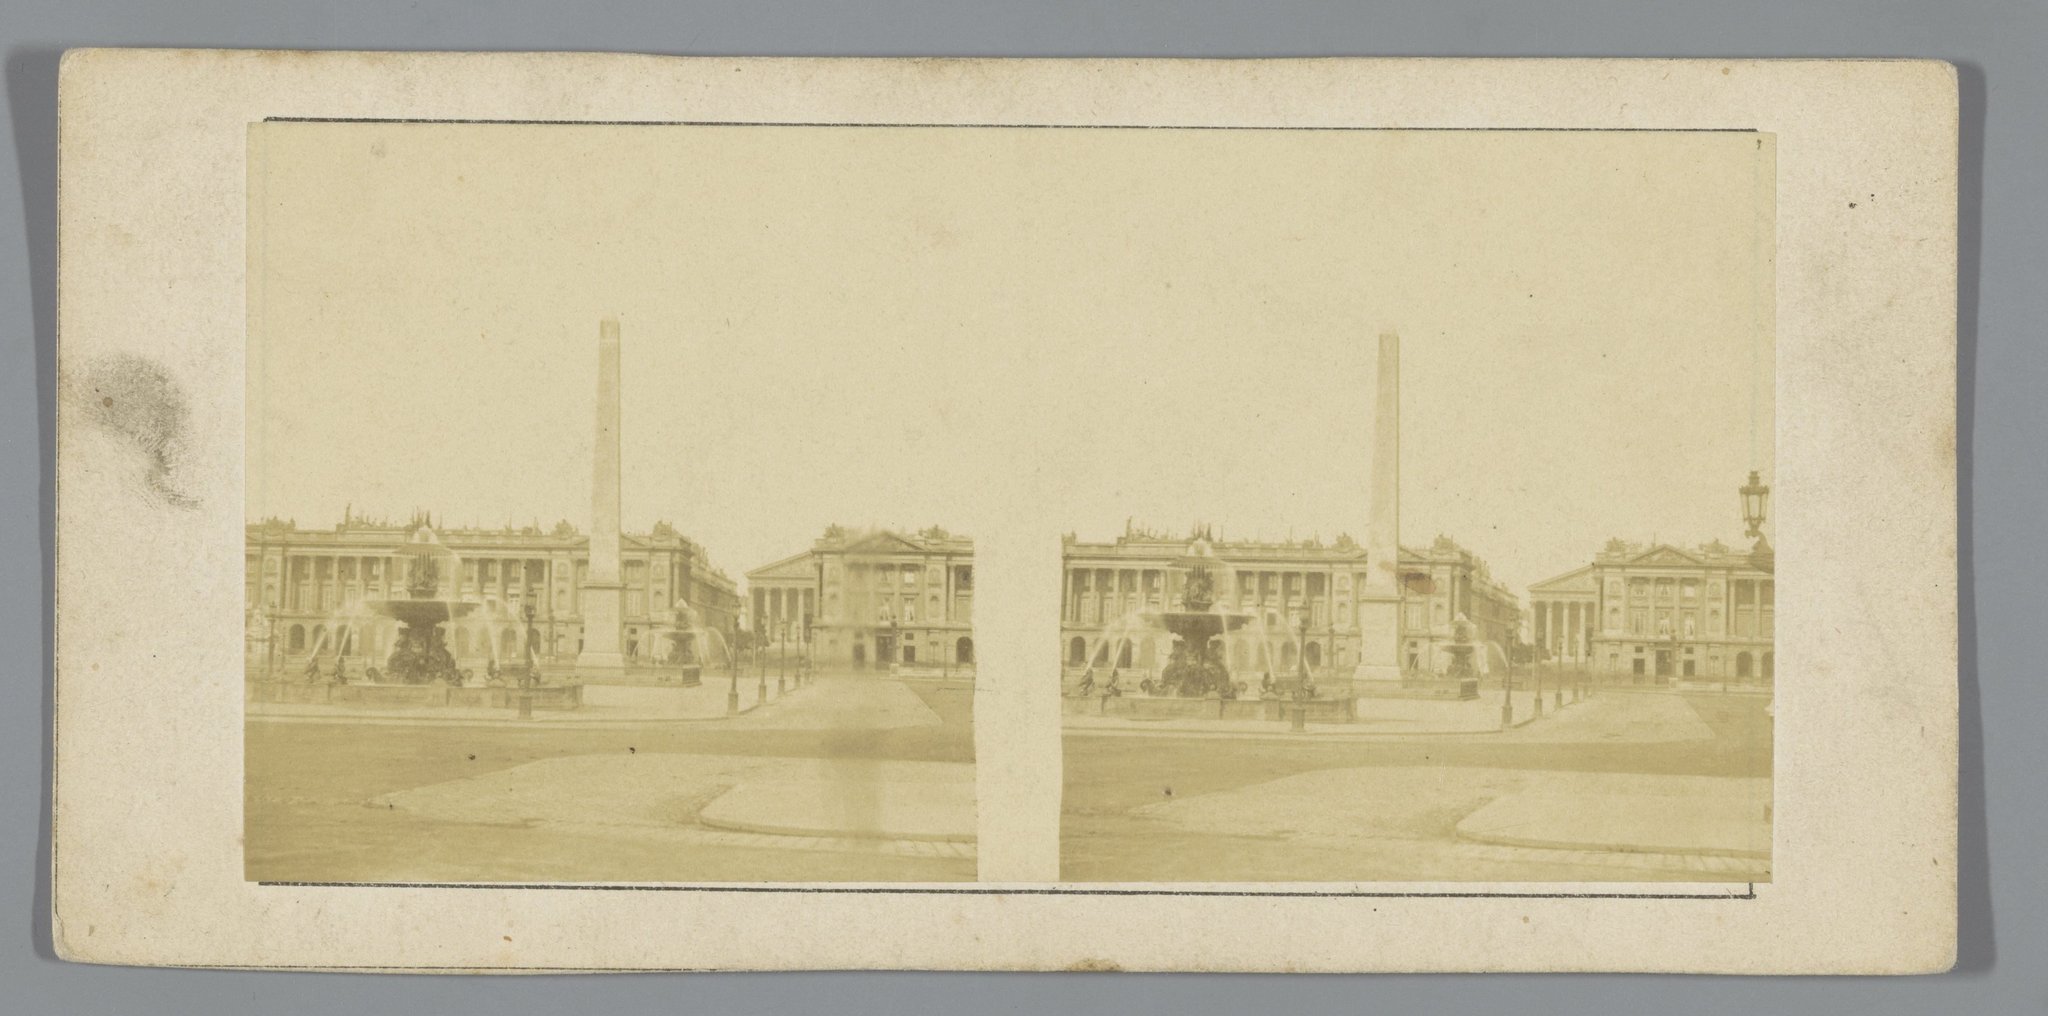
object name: stereograph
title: Gezicht op Place de la Concorde, Parijs, met de obelisk van Luxor, het Hôtel de la Marine en het Hôtel de Crillon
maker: Anonymous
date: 1857-1863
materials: cardboard, paper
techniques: albumen print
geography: paris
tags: square, place, circus, etc., ornamental fountain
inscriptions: inscription: ‘D. 79’, number: ‘162’